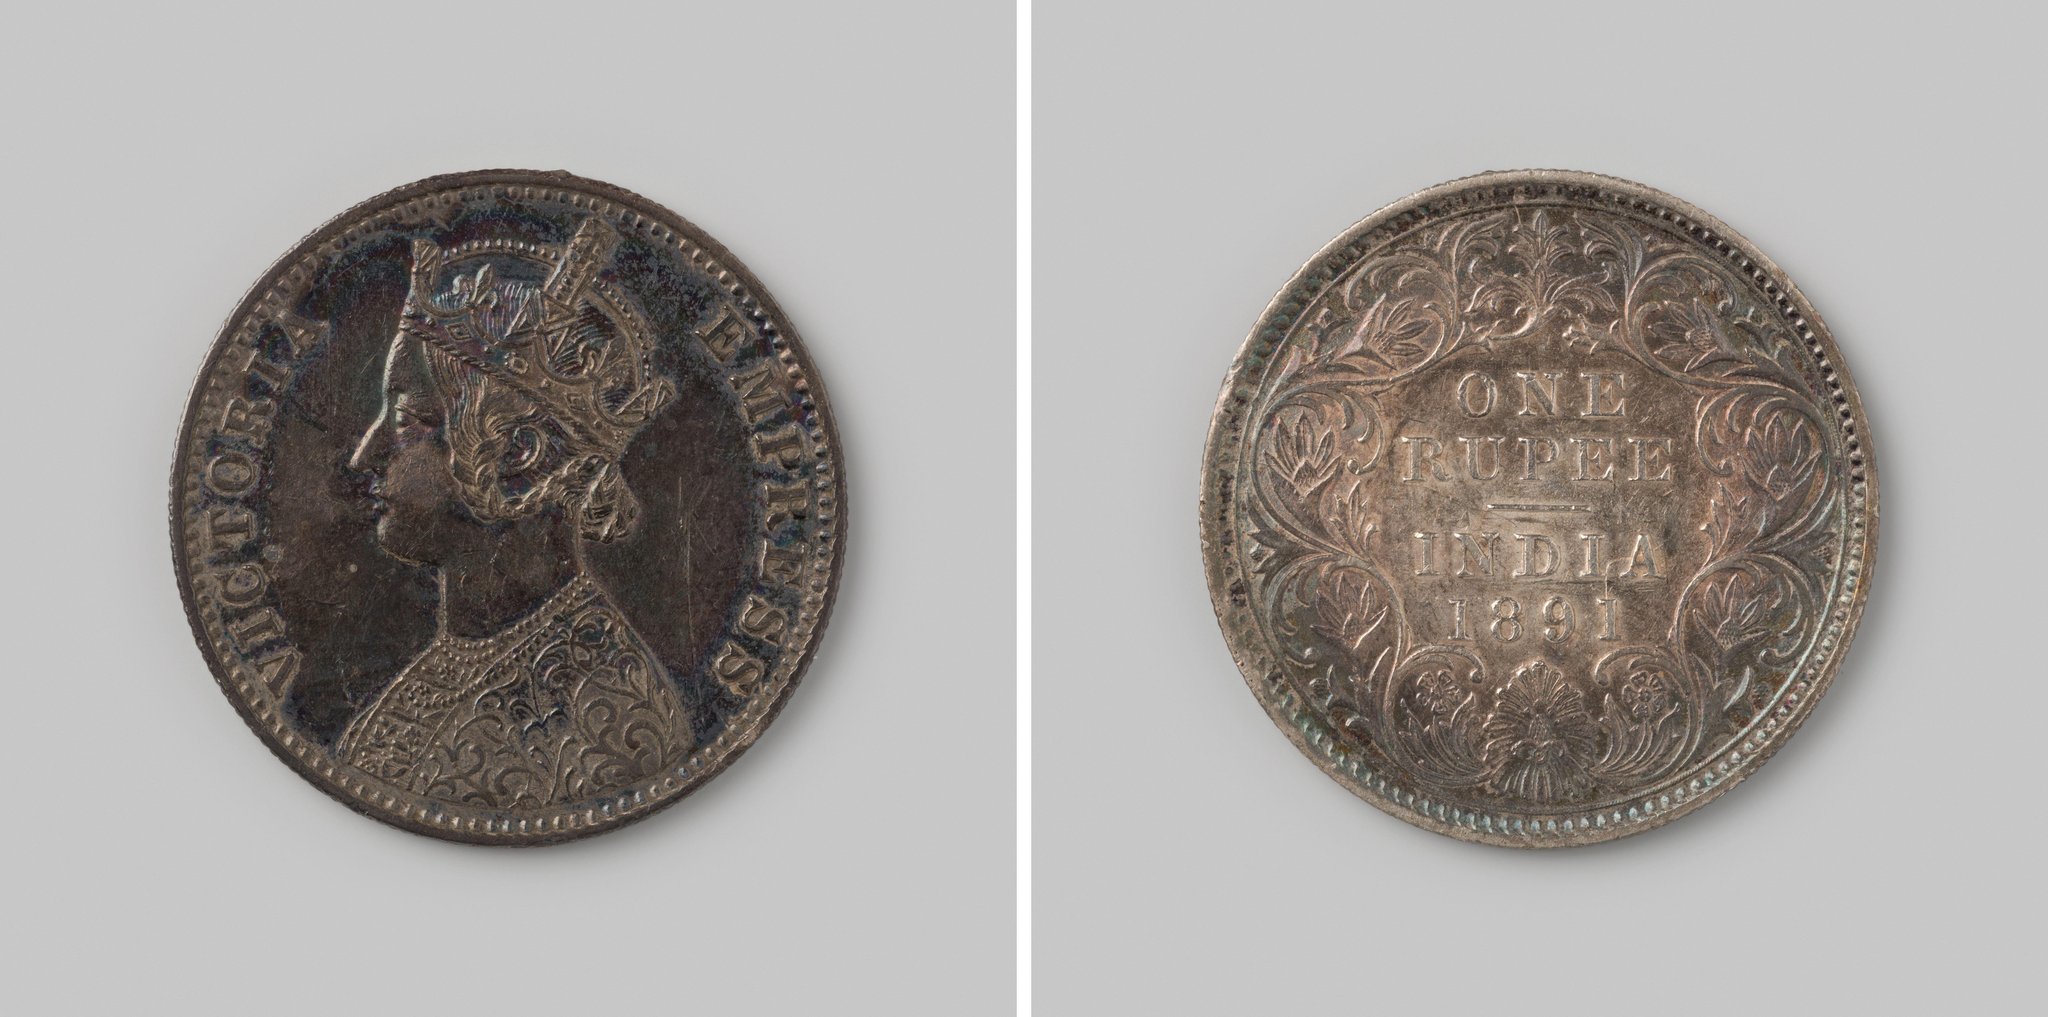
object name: coin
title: Roepie uit India van keizerin Victoria, 1891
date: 1891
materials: silver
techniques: striking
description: Zilveren munt. Voorzijde: gekroond borstbeeld van keizerin Victoria naar links. Keerzijde: binnen een kring van lotusbloemen in twee regels waarde-aanduiding: one rupee, waaronder lands-aanduiding. Daaronder jaartal. Kartelrand.